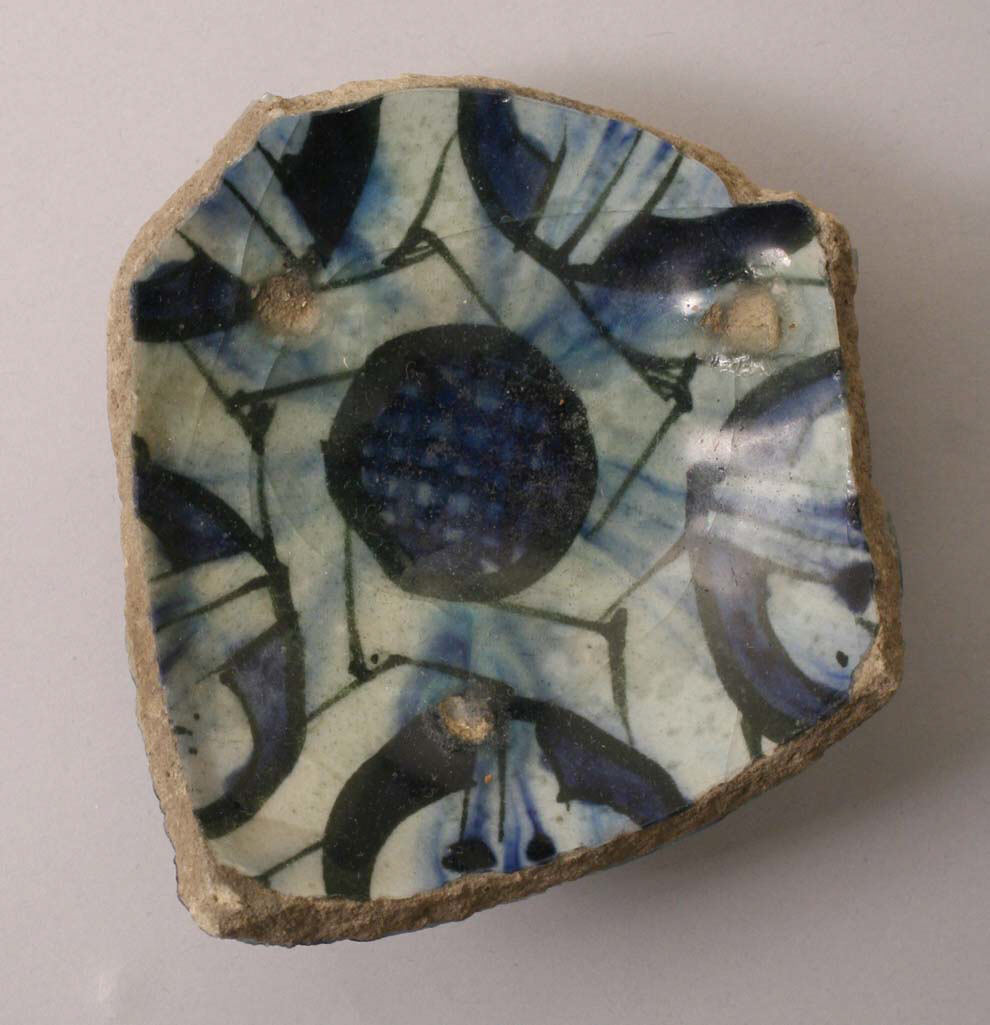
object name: ceramic fragment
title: Fragment of a Bowl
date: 1301-1400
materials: glaze, stonepaste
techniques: painting, polychrome, underglaze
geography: egypt or syria